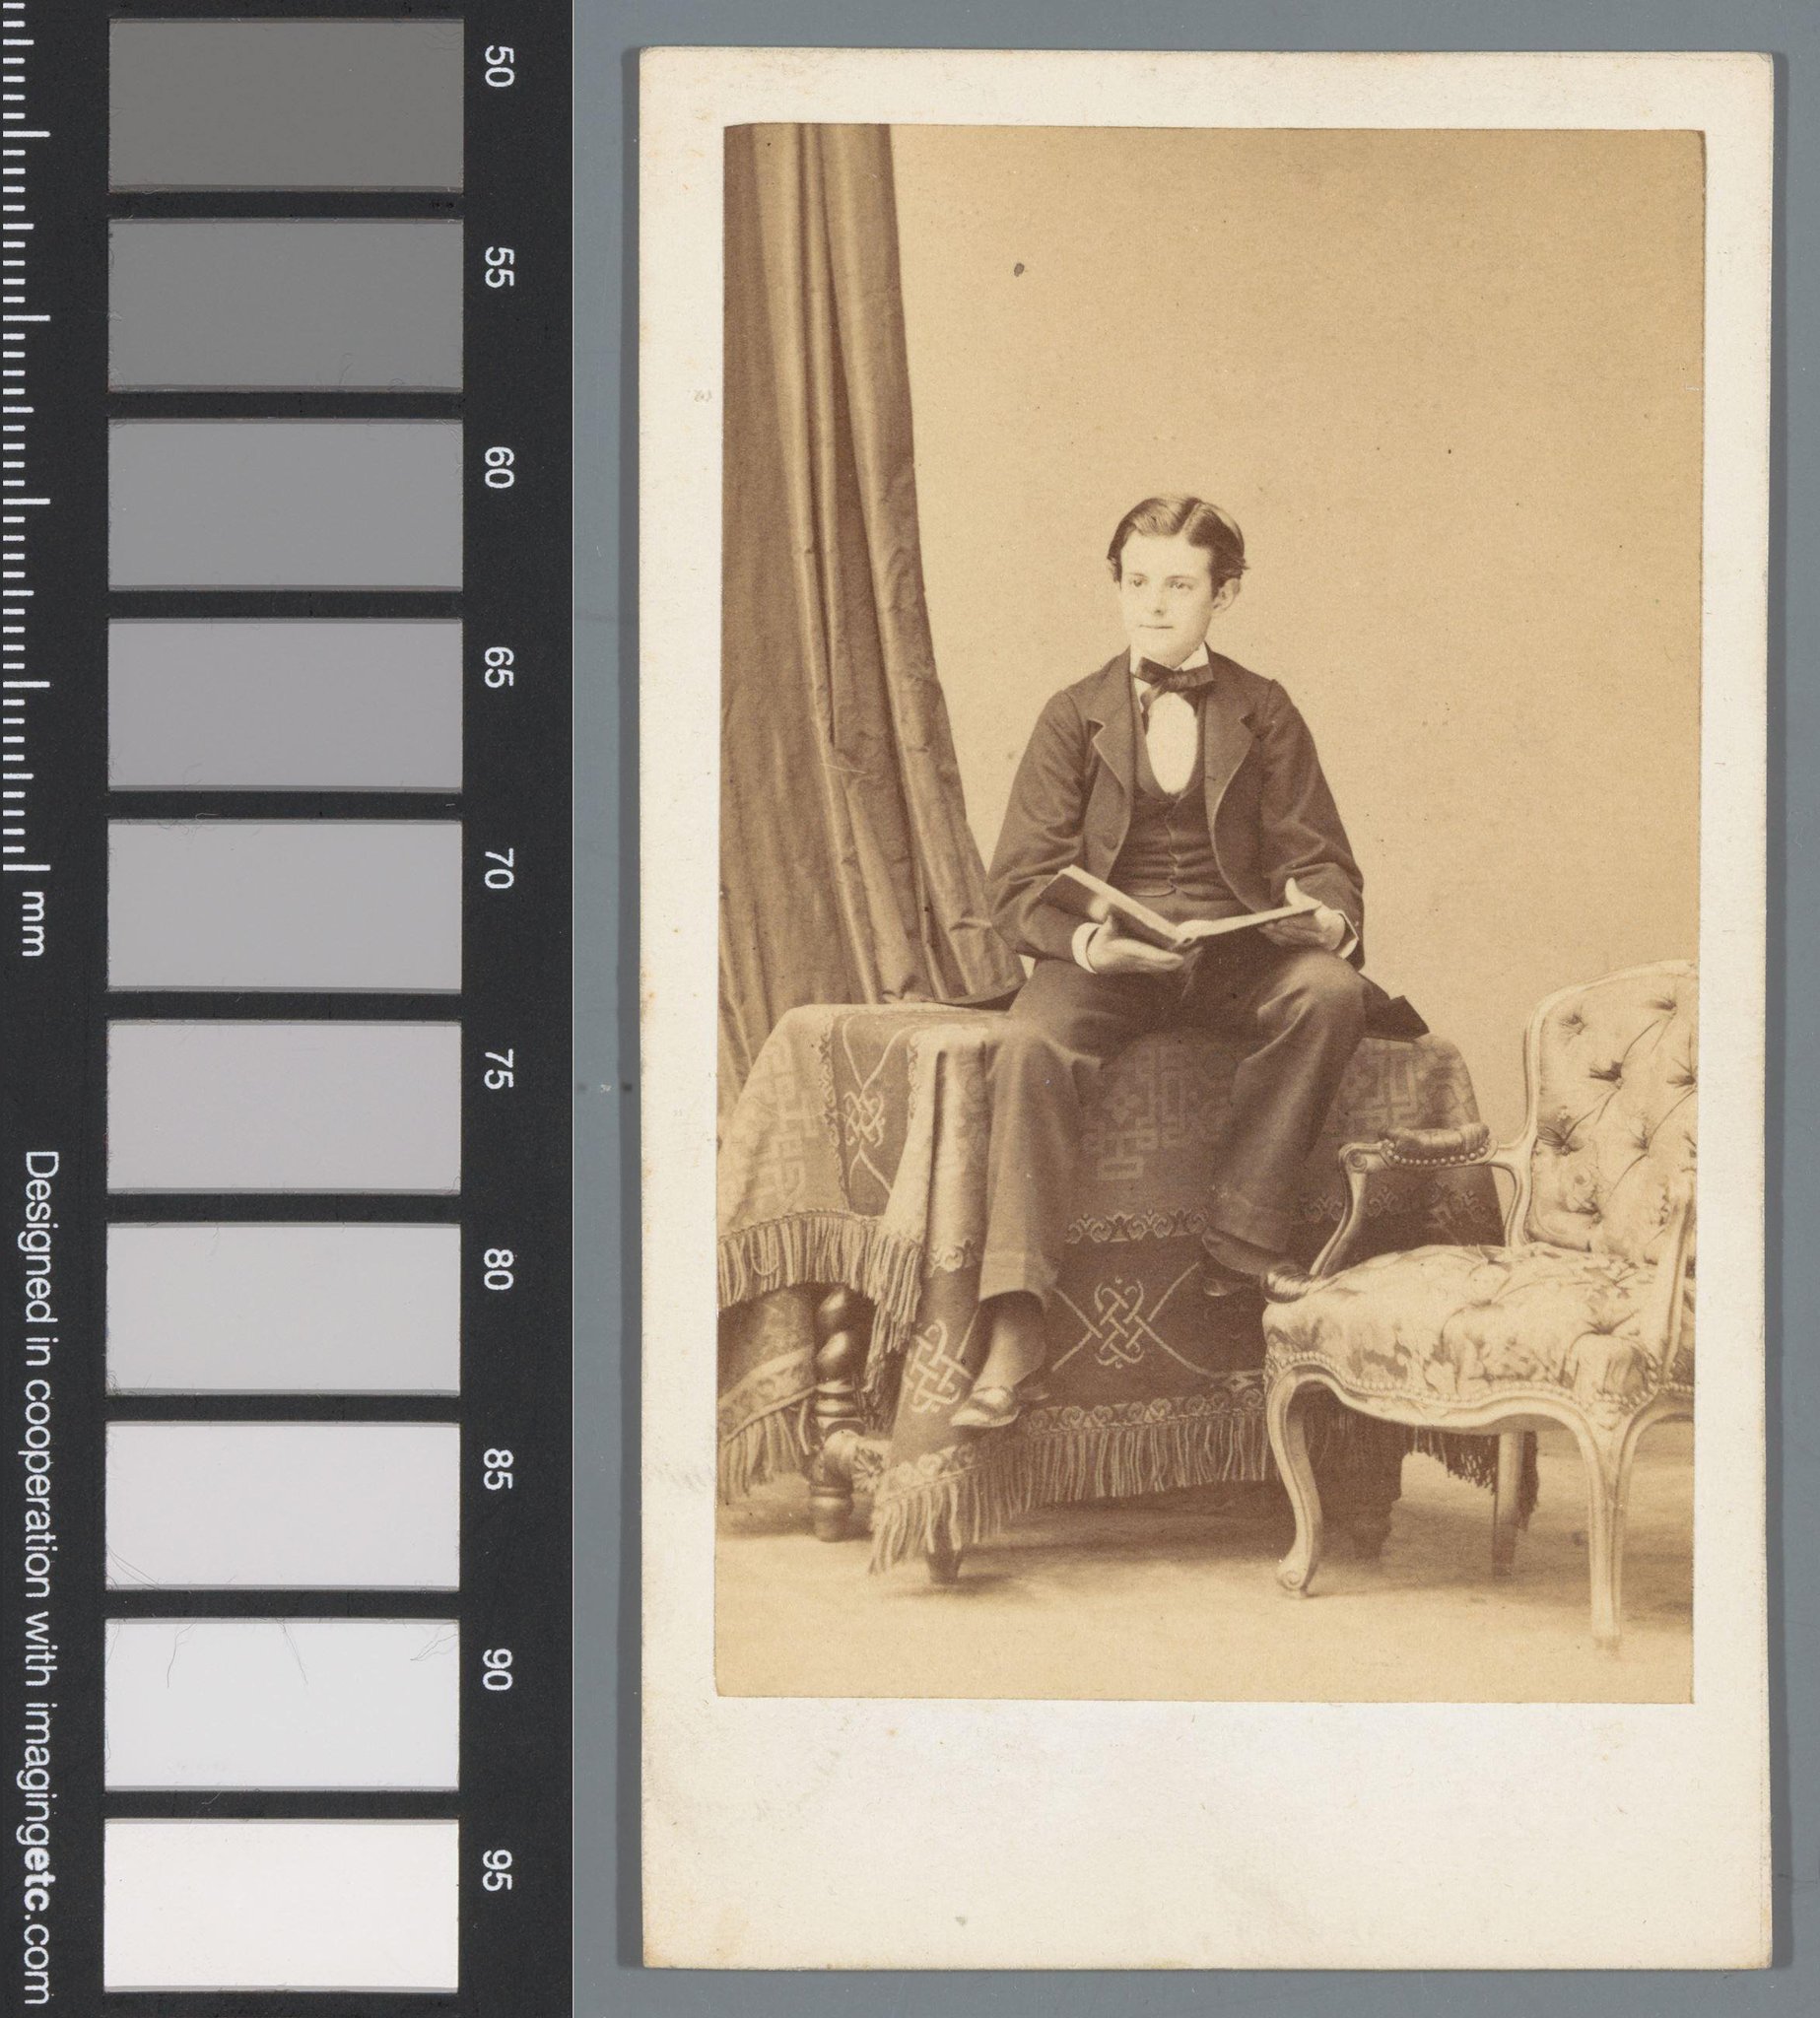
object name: carte de visite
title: Portret van een onbekende jongen, zittend op tafel met een opengeslagen boek in zijn handen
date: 1854-1889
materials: cardboard, paper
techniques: albumen print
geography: paris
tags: seating furniture, boy (child between toddler and youth), historical persons, book - mm - book open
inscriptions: stamp: ‘DISDERI & Cie/ PHOTOGRAPHES de S.M.L'EMPEREUR/ 8, Boulevart des Italiens/ PARIS’